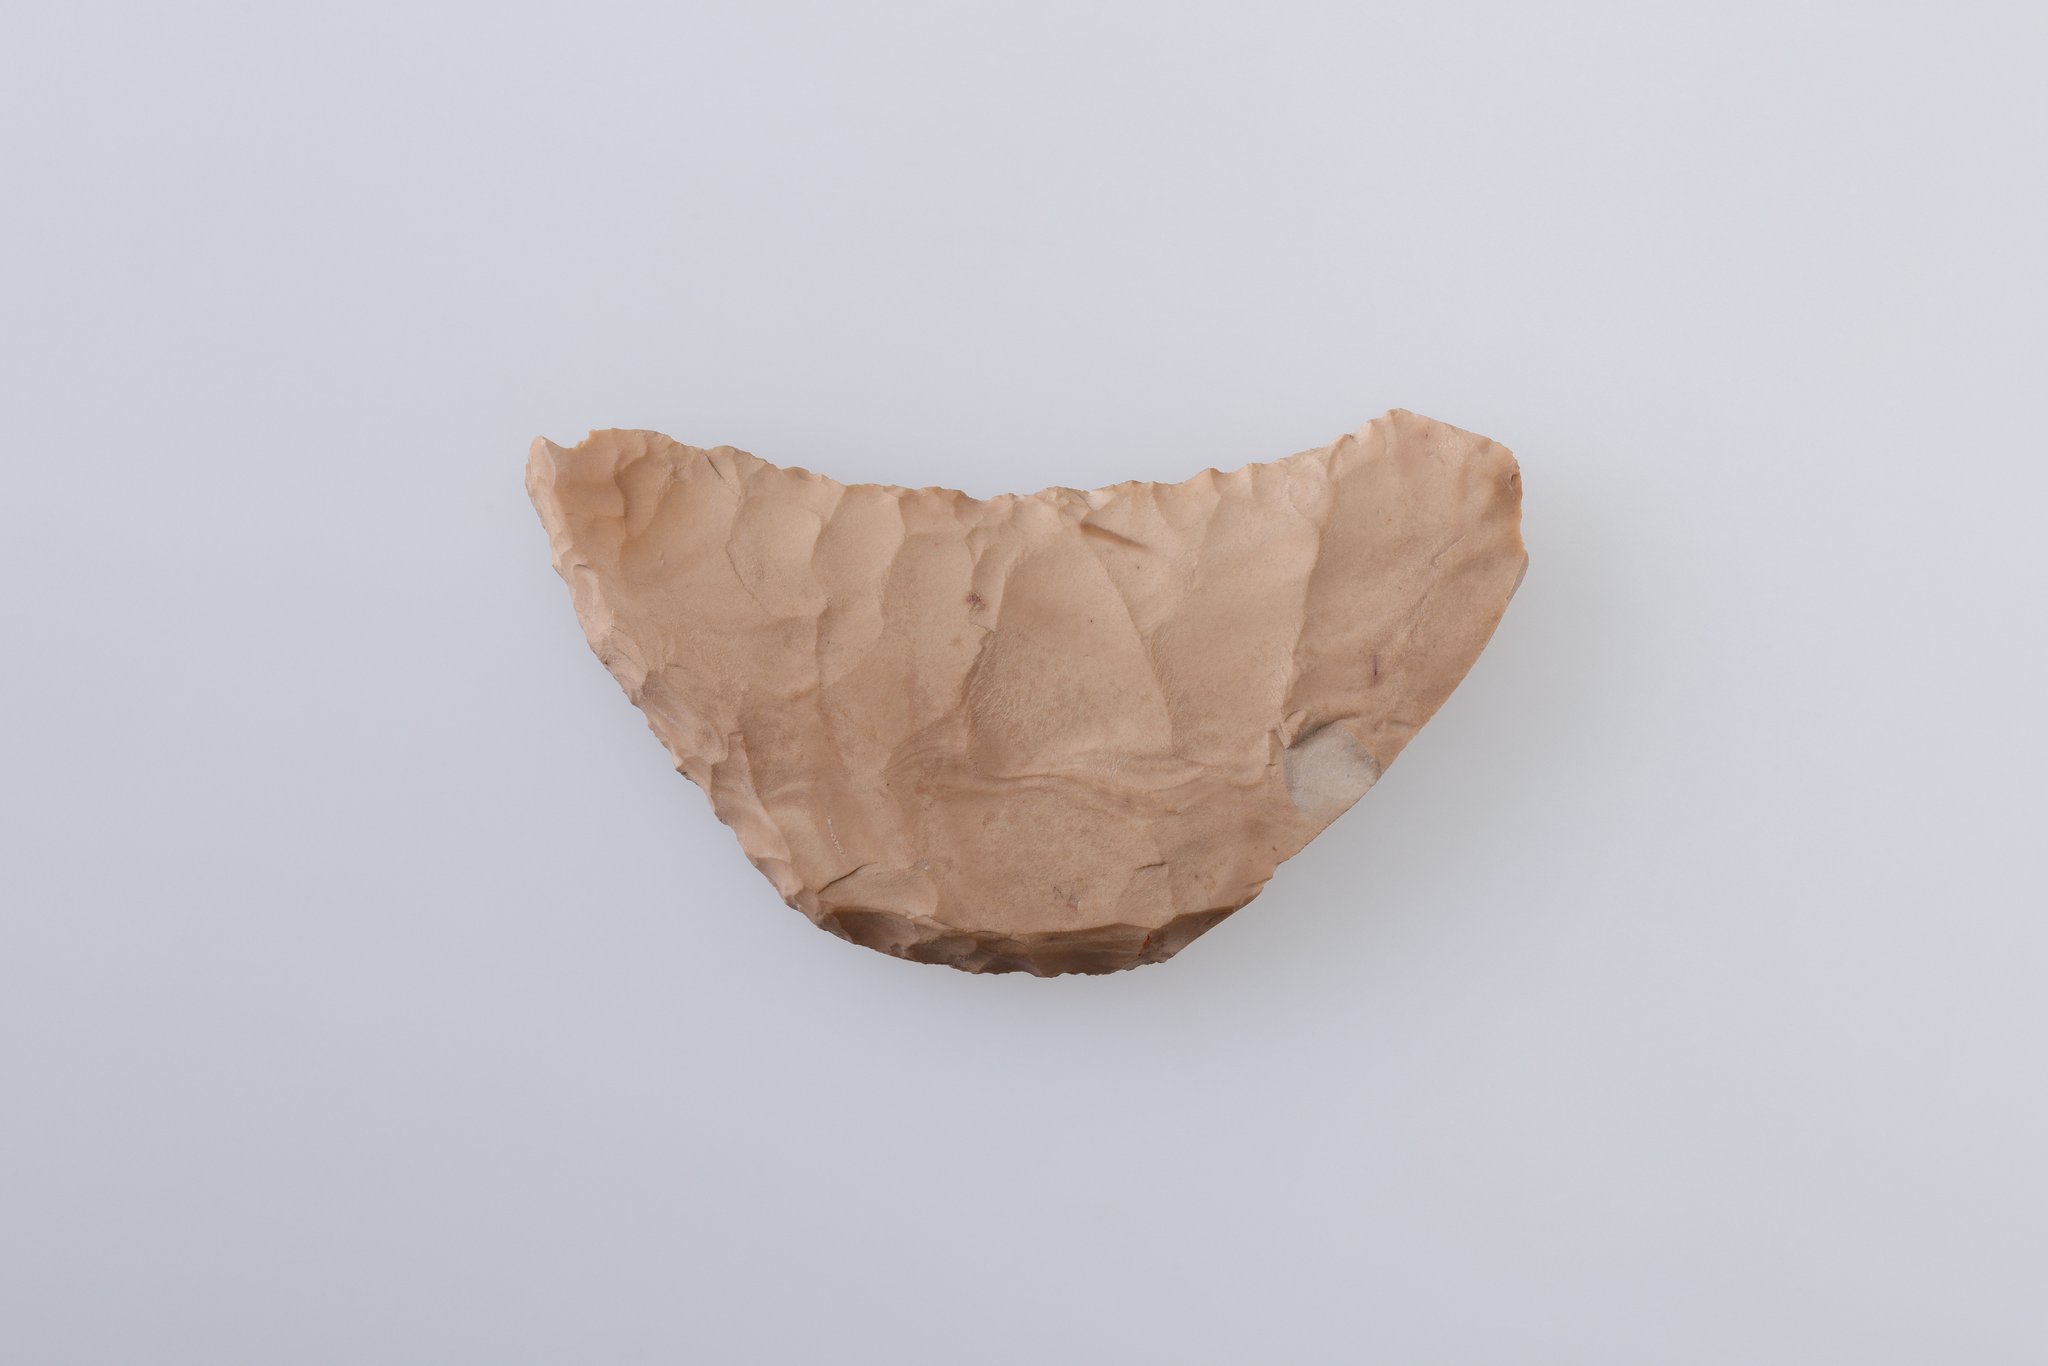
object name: tool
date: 3100-2649 BCE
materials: stone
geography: egypt